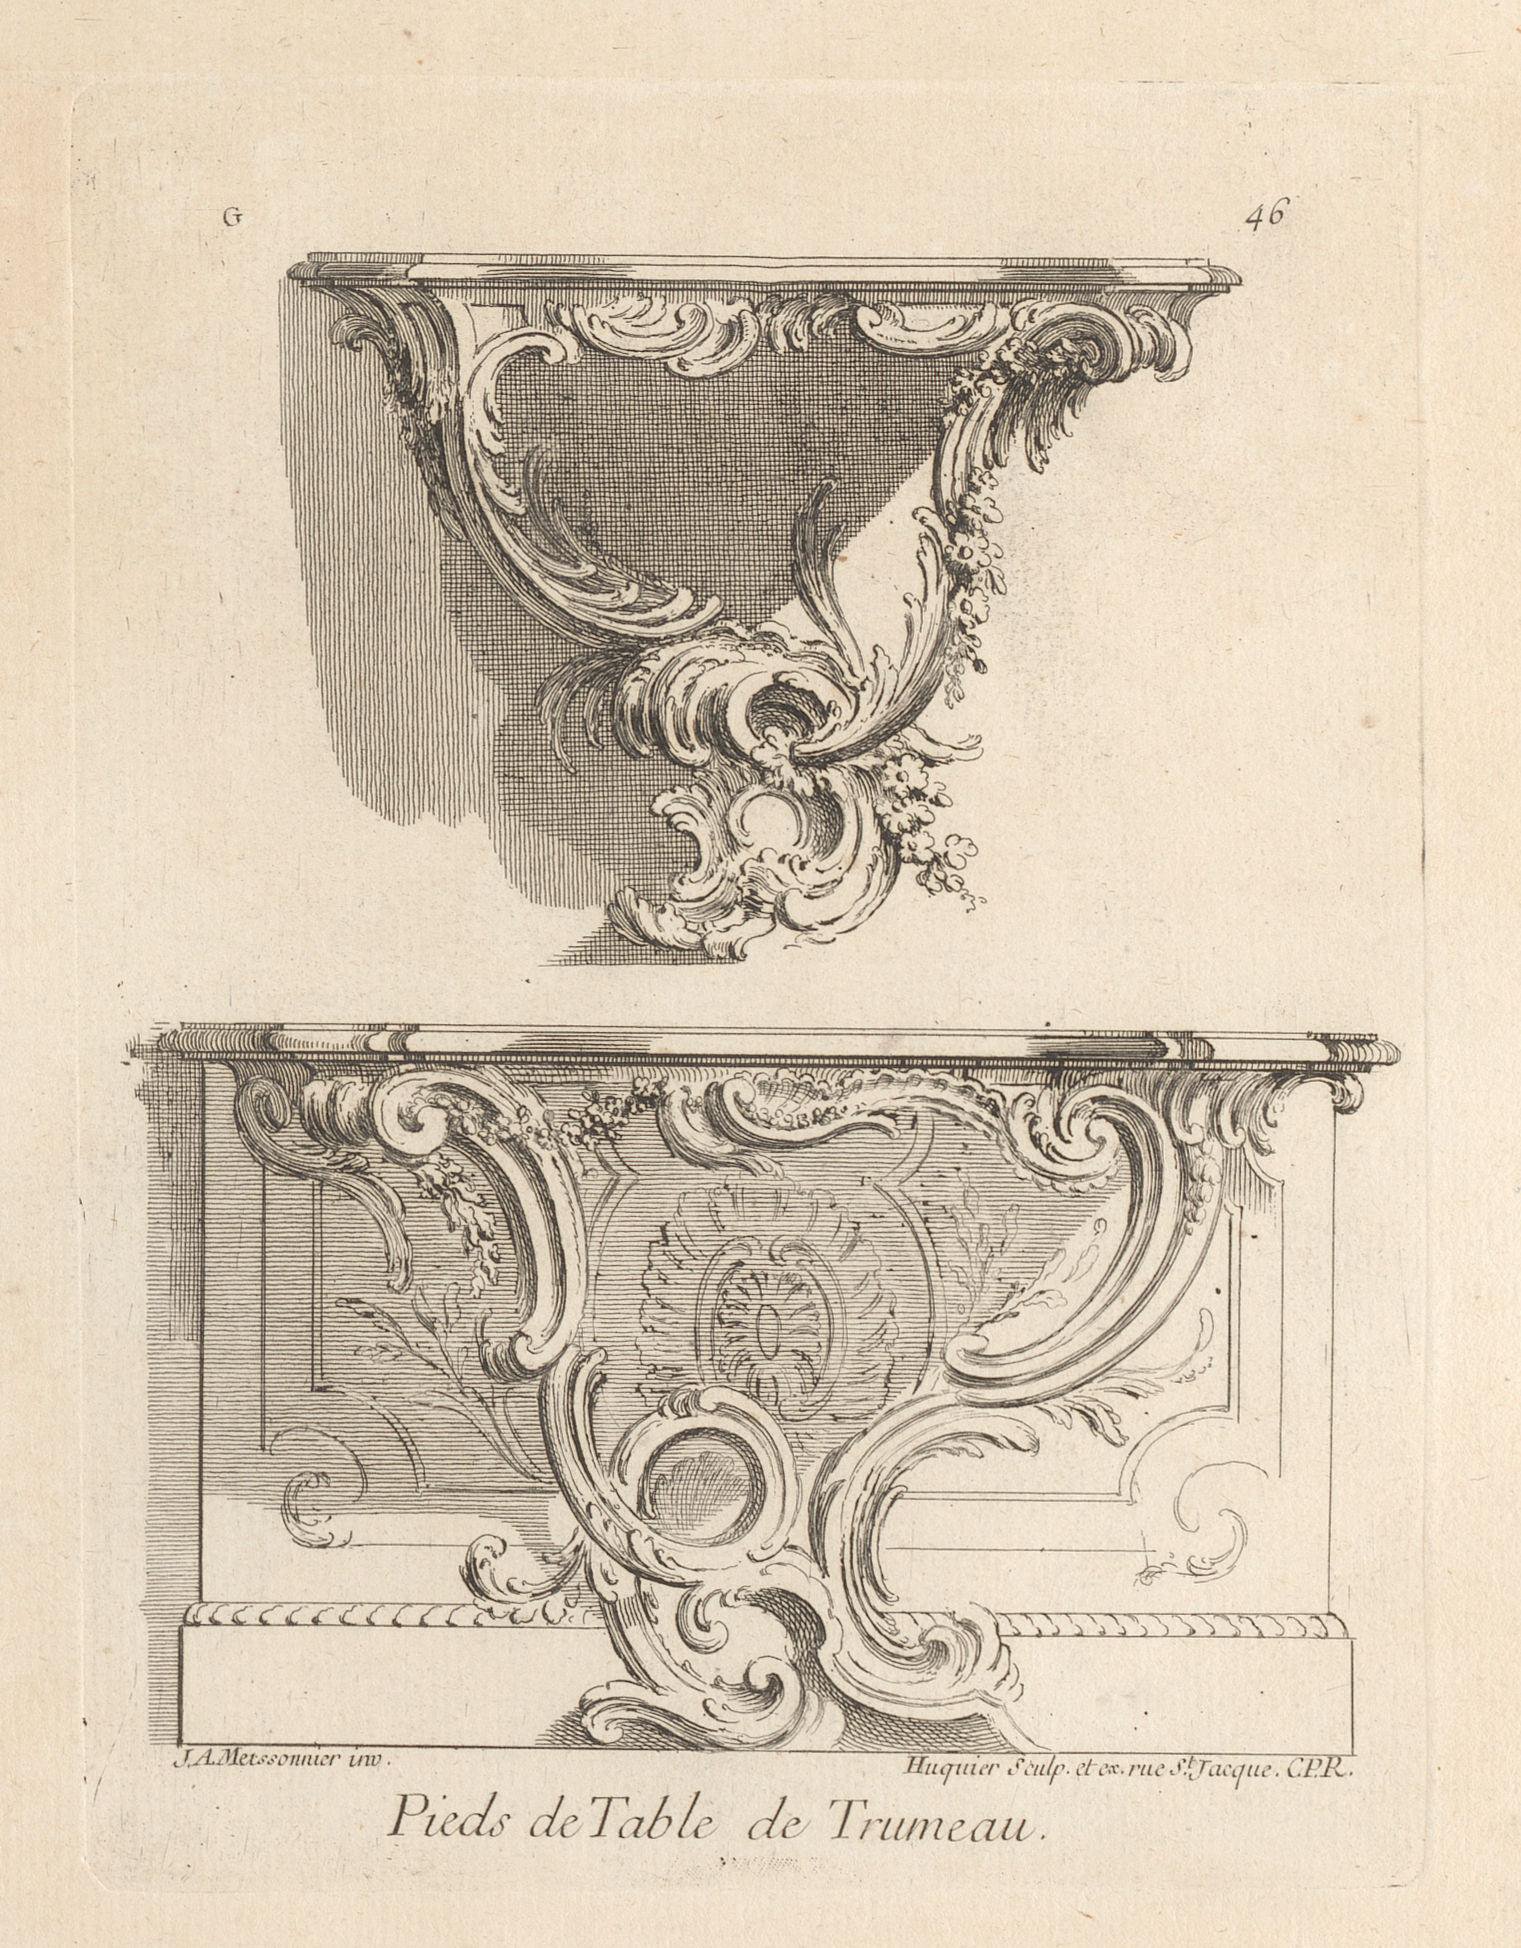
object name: print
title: Oeuvre van Juste Aurele Meissonnier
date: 1738-1749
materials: paper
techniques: etching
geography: paris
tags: table, work of applied art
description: Deze prent maakt deel uit van de serie "Cinquieme livre d'ornemens inventés par J.A. Meissonnier", een van de delen van de monumentale reeks "Oeuvre de Juste Aurele Meissonnier".